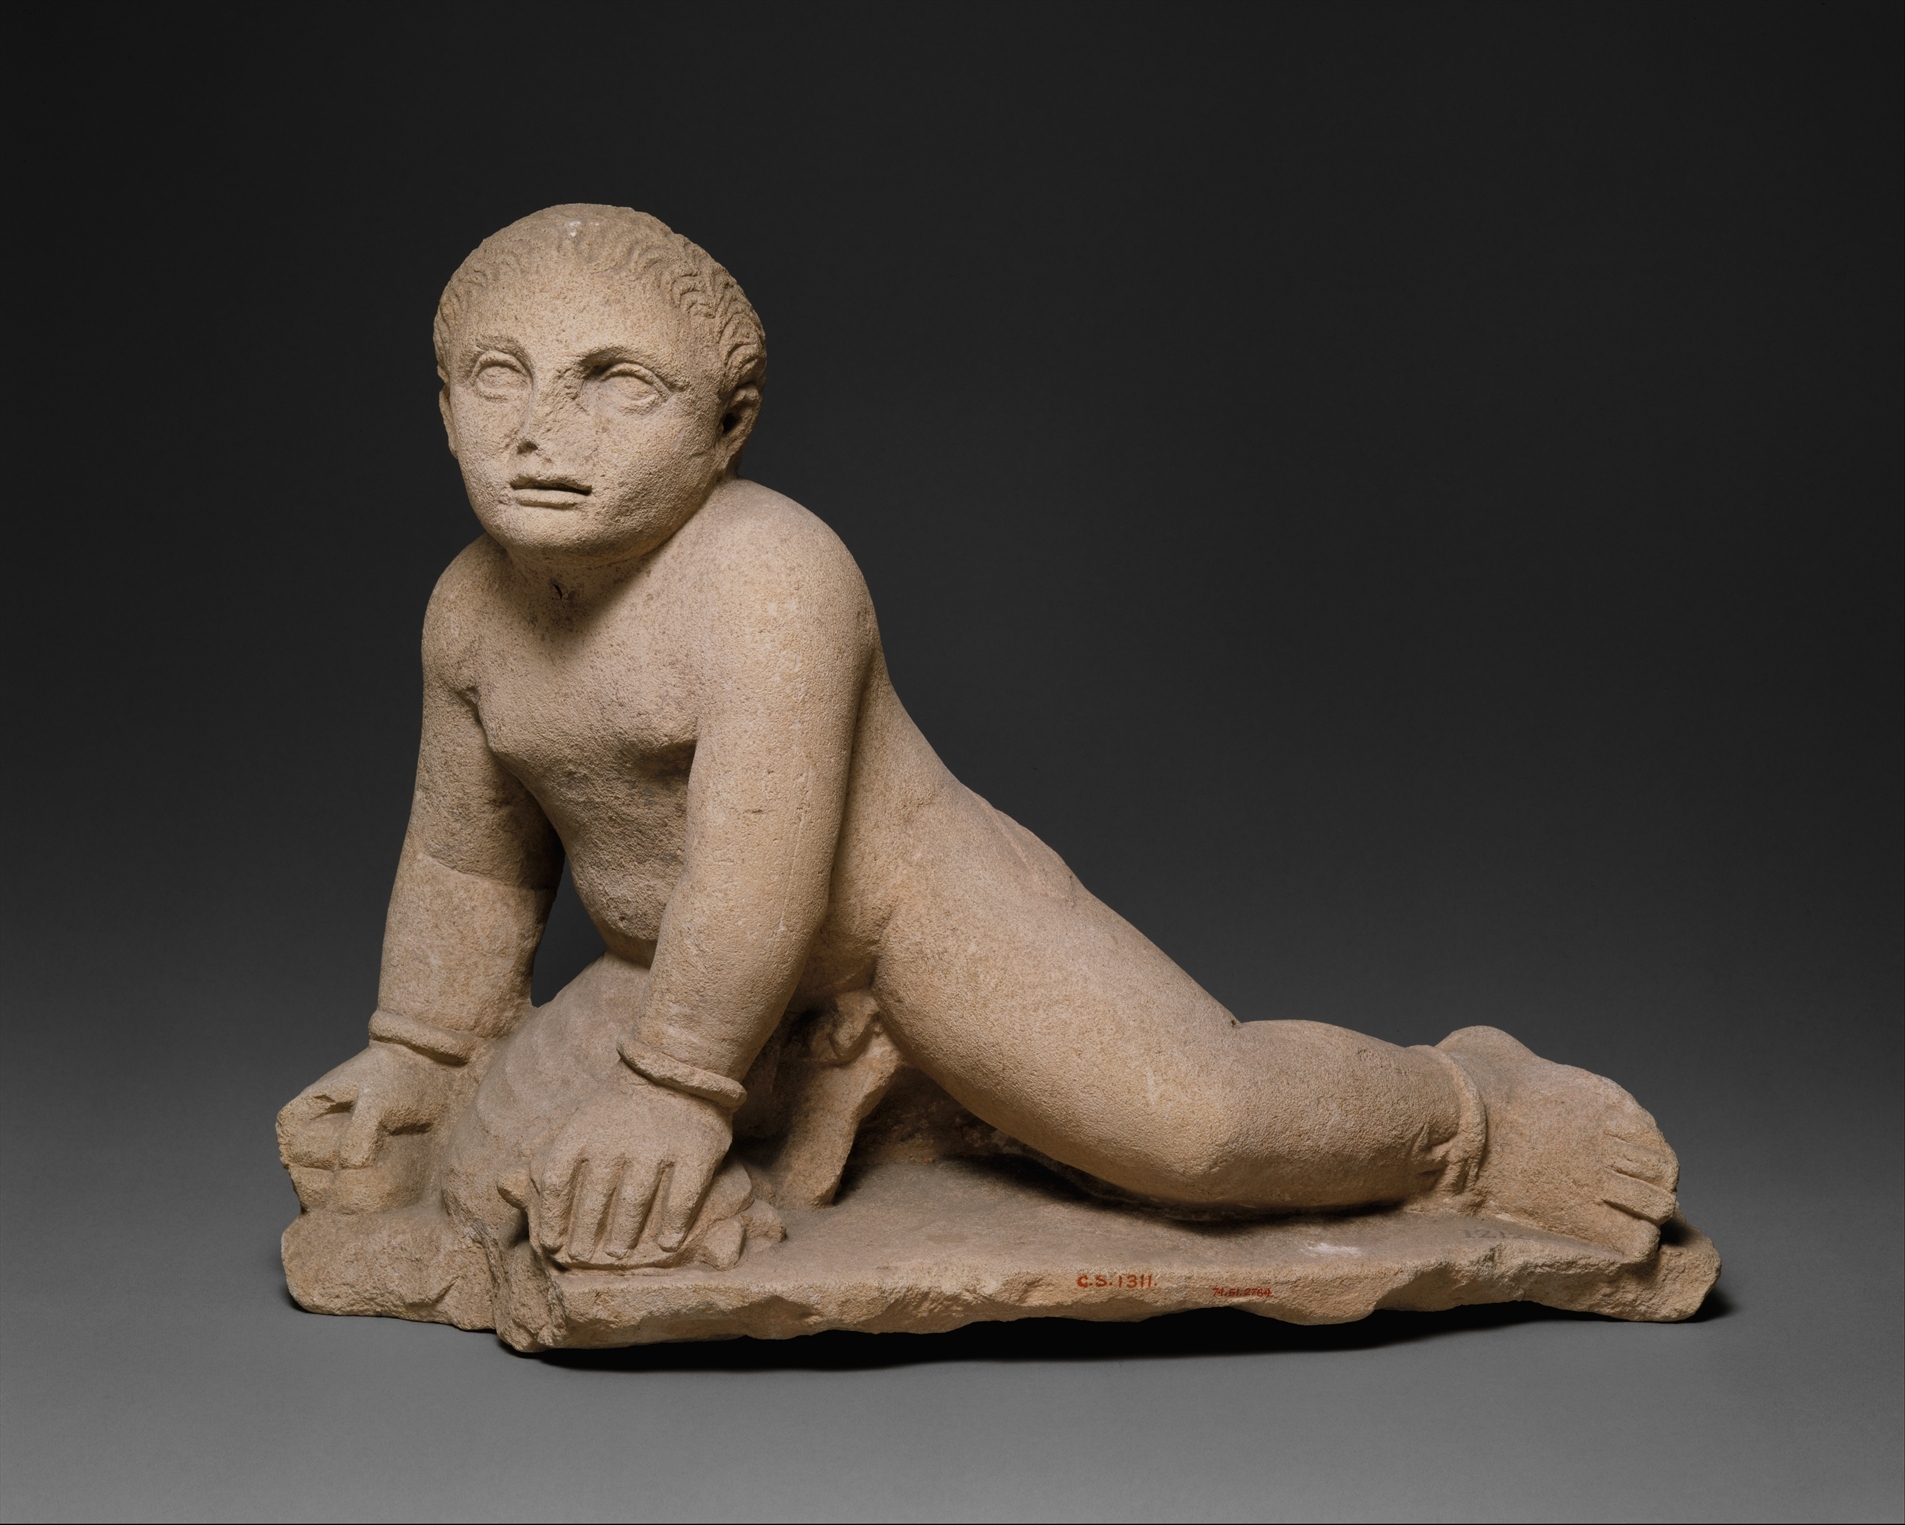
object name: statuette of a temple boy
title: Limestone temple boy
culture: cypriot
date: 434-401 BCE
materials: limestone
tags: boys